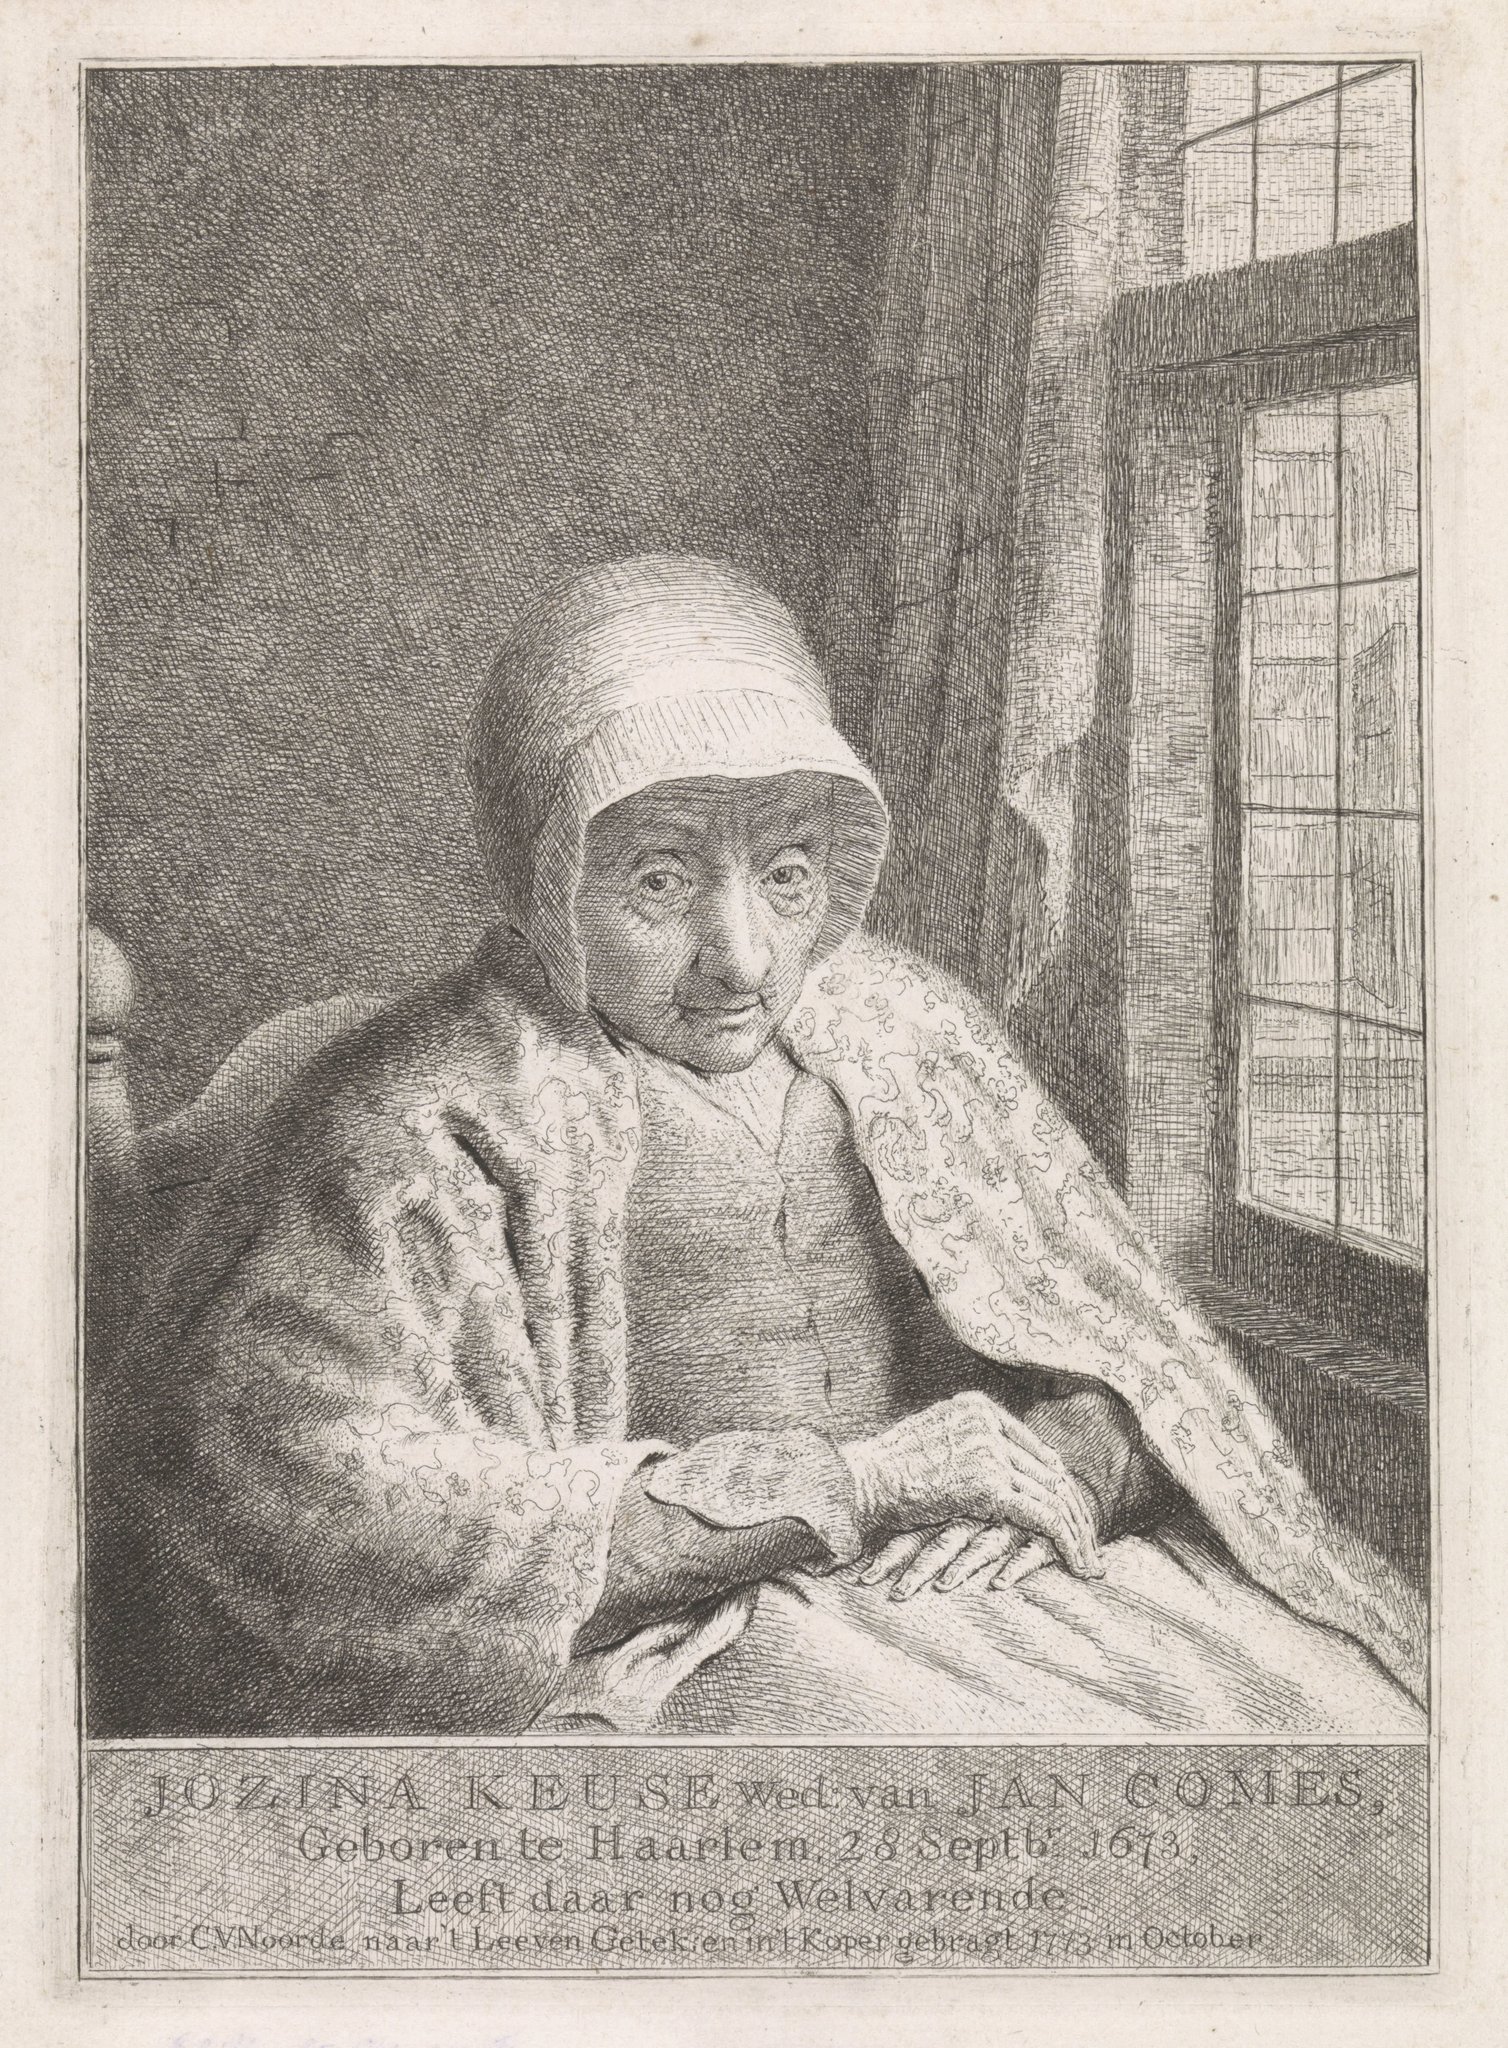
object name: print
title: Portret van Jozina Keuse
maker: cornelis van noorde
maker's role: draughtsman, print maker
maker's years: 1731-1795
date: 1773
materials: paper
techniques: engraving, etching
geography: haarlem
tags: jozina keuse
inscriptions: collector's mark: Lugt 2233, collector's mark: Lugt 2228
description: Portret van Jozina Keuse, op 100-jarige leeftijd, zittend bij het raam.